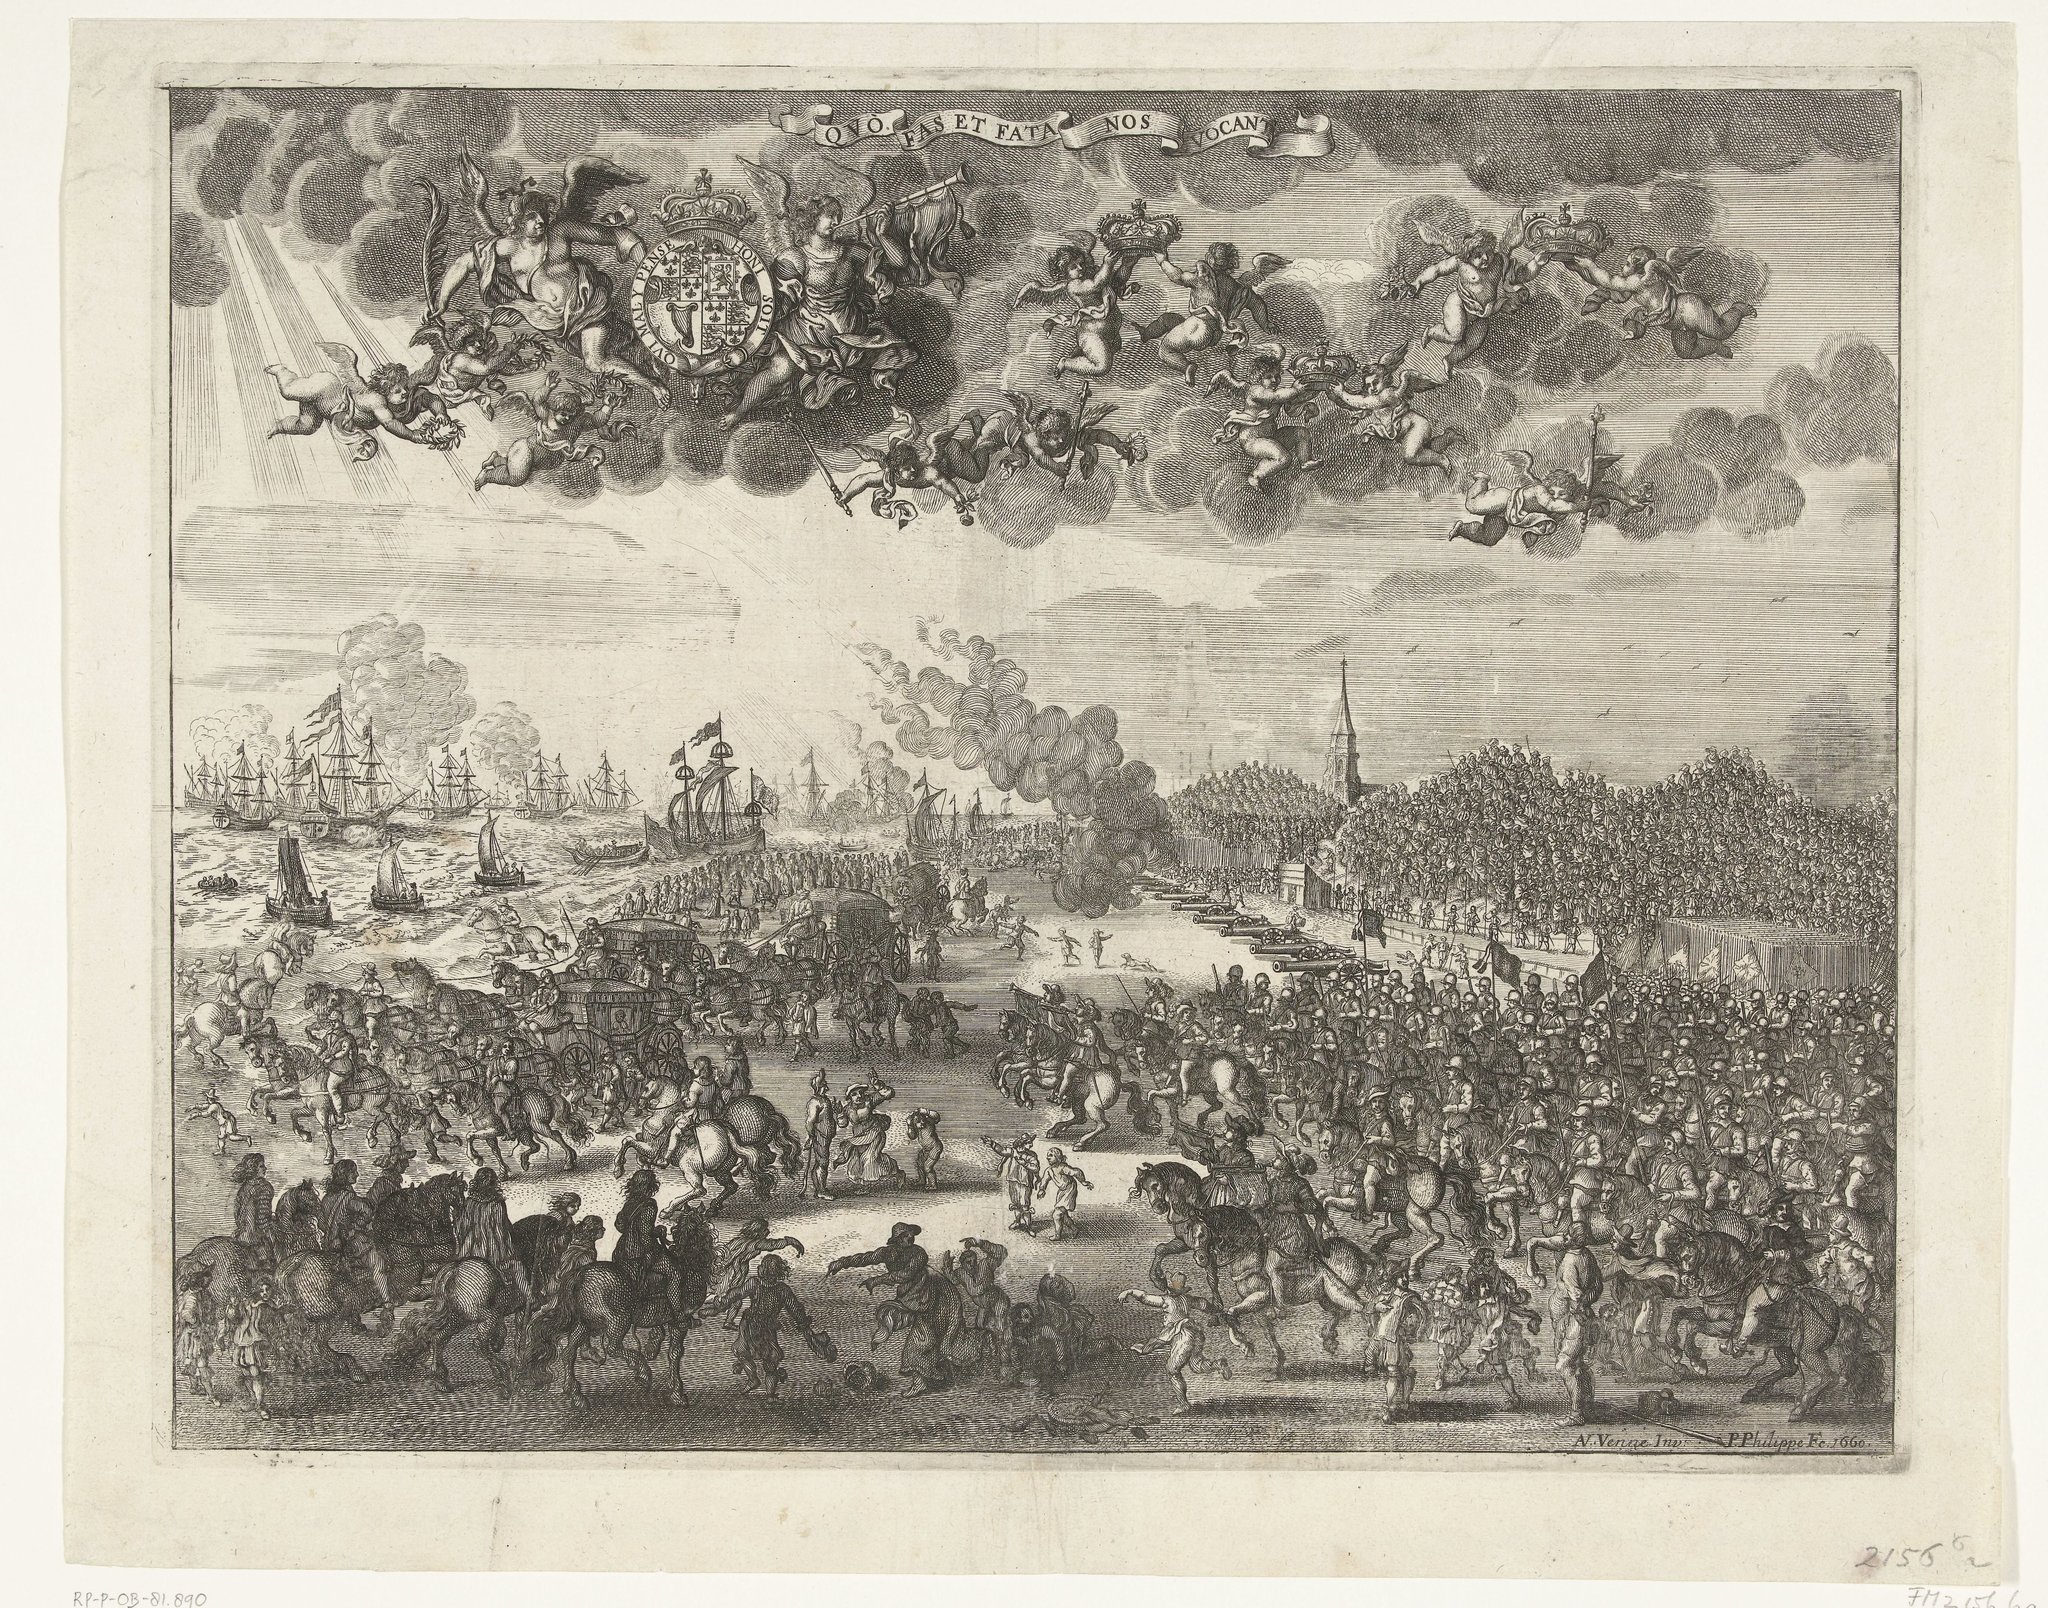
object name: print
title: Vertrek van Karel II uit Scheveningen naar Engeland, 1660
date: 1660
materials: paper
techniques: engraving, etching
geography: the hague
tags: london, karel ii (koning van engeland), departure ~ travelling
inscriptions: date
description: Het vertrek van de Engelse koning Karel II vanuit Scheveningen naar Engeland, 2 juni 1660. Episode tijdens zijn rondreis door en vertrek uit de Nederlanden. Links de koetsen met de koning en zijn gevolg, rechts ruiters, kanonnen en toeschouwers op de duinen. Op zee wachten de schepen om de koning naar Engeland te brengen. In de lucht putti en de Faam met het wapen van de Engelse koning en een banderol met Latijnse spreuk.